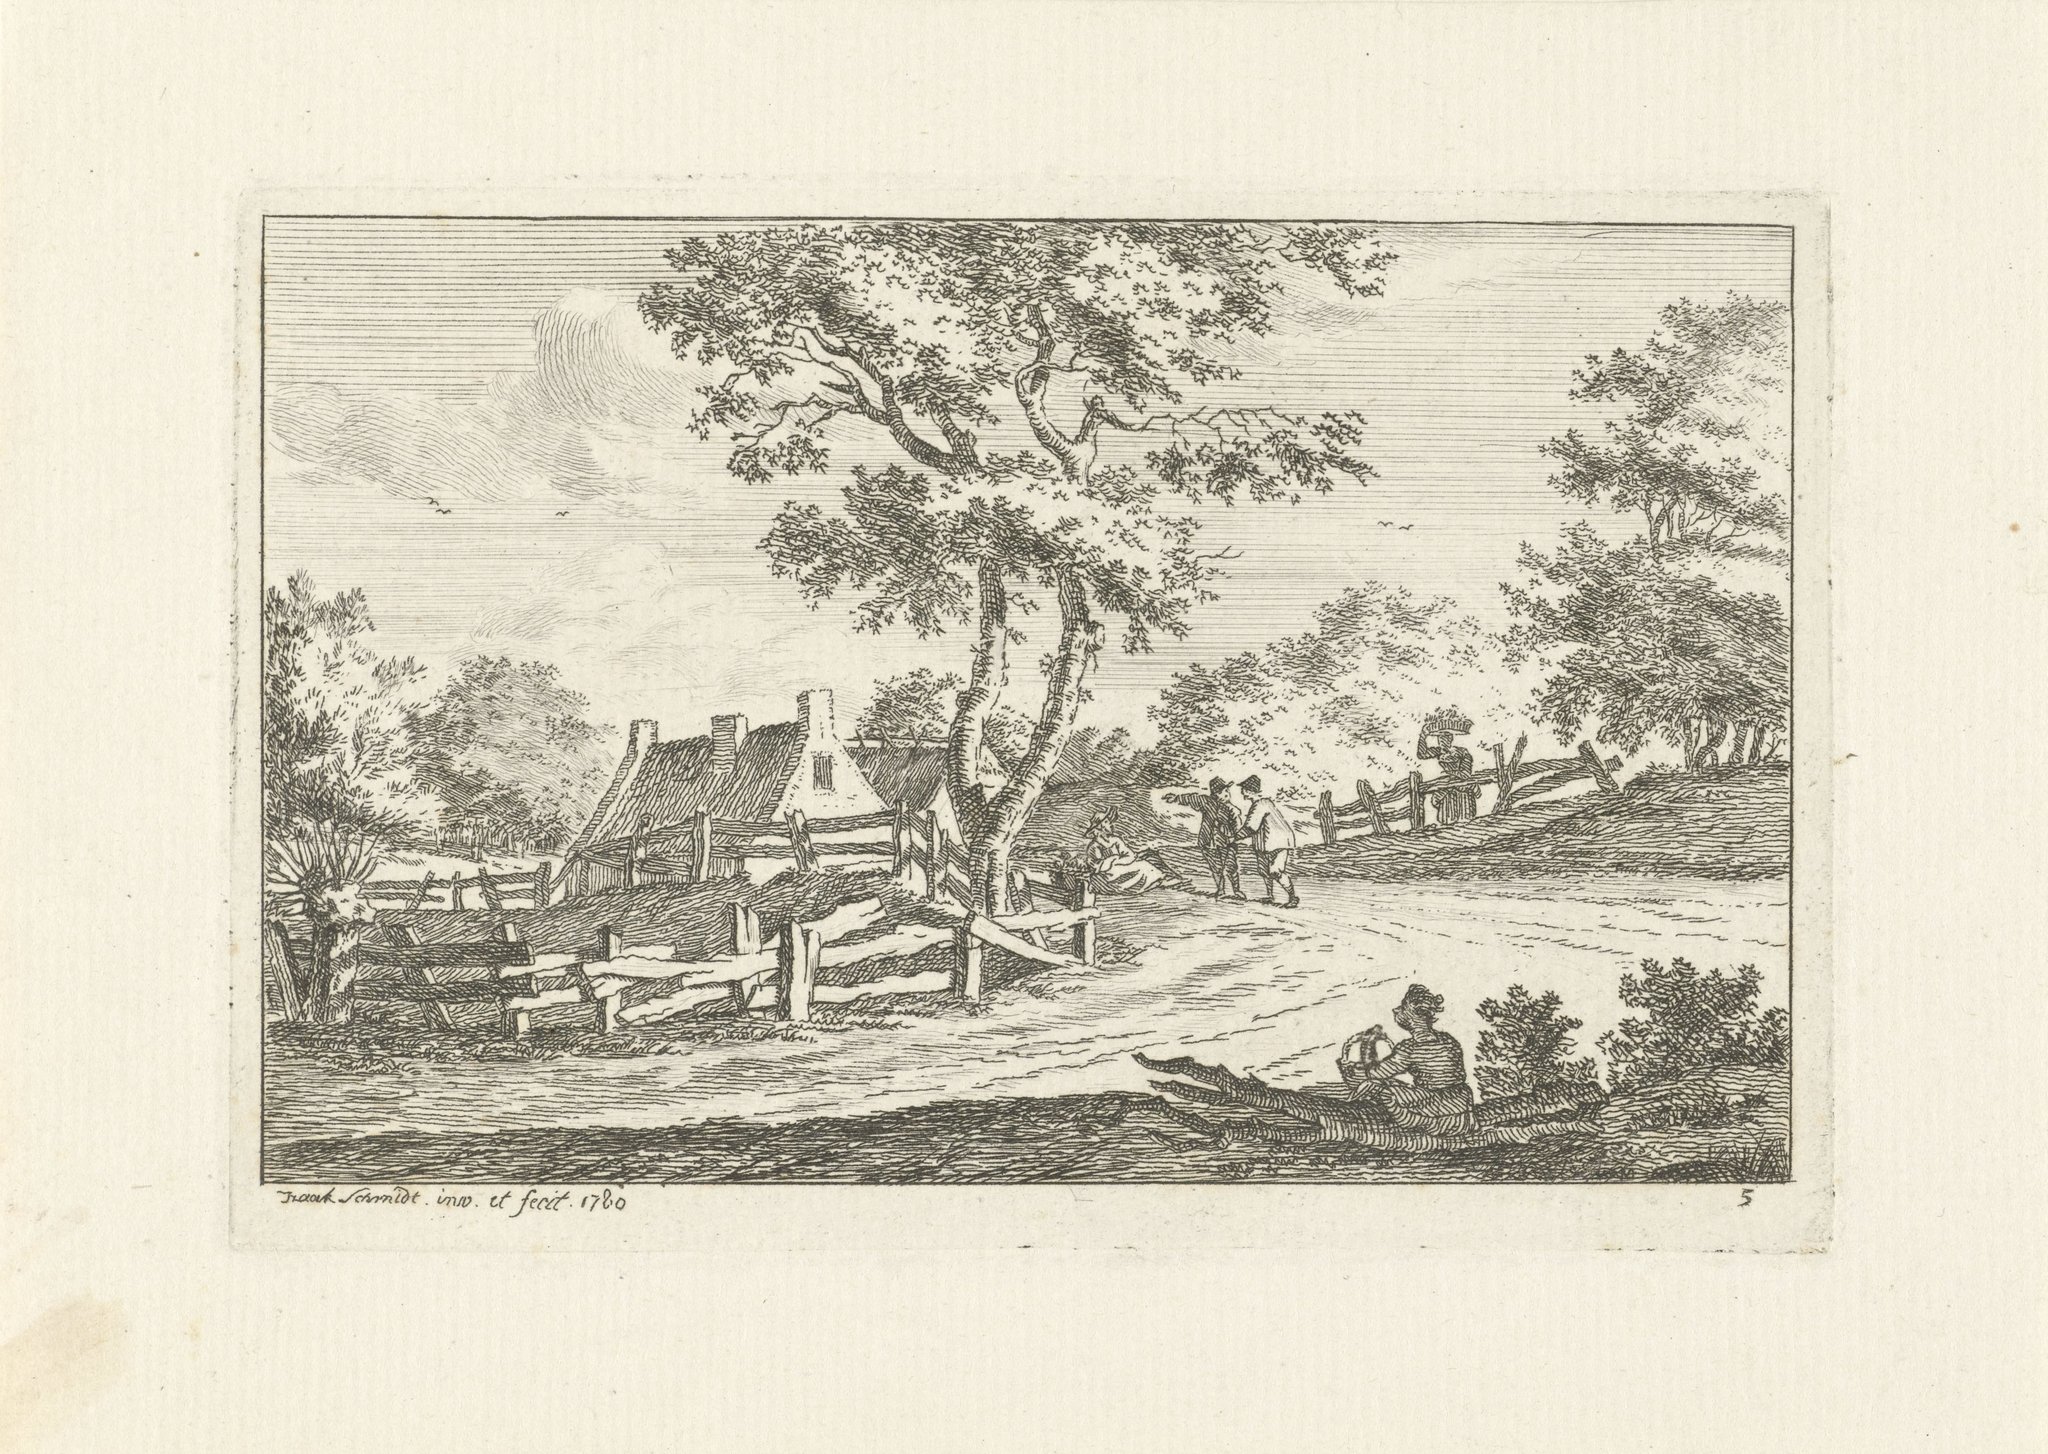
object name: print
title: Boerderij aan een bospad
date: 1780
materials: paper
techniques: etching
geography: amsterdam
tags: forest path or lane, conversation, dialogue; conversation piece, farm (building)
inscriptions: collector's mark: Lugt 240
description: Gezicht op een bospad waar een boerenhoeve aan ligt. Naast het pad zitten op verschillende plekken vrouwen te rusten, en op het pad zijn twee mannen met elkaar in gesprek. De prent is deel van een serie van zes prenten met landschappen.